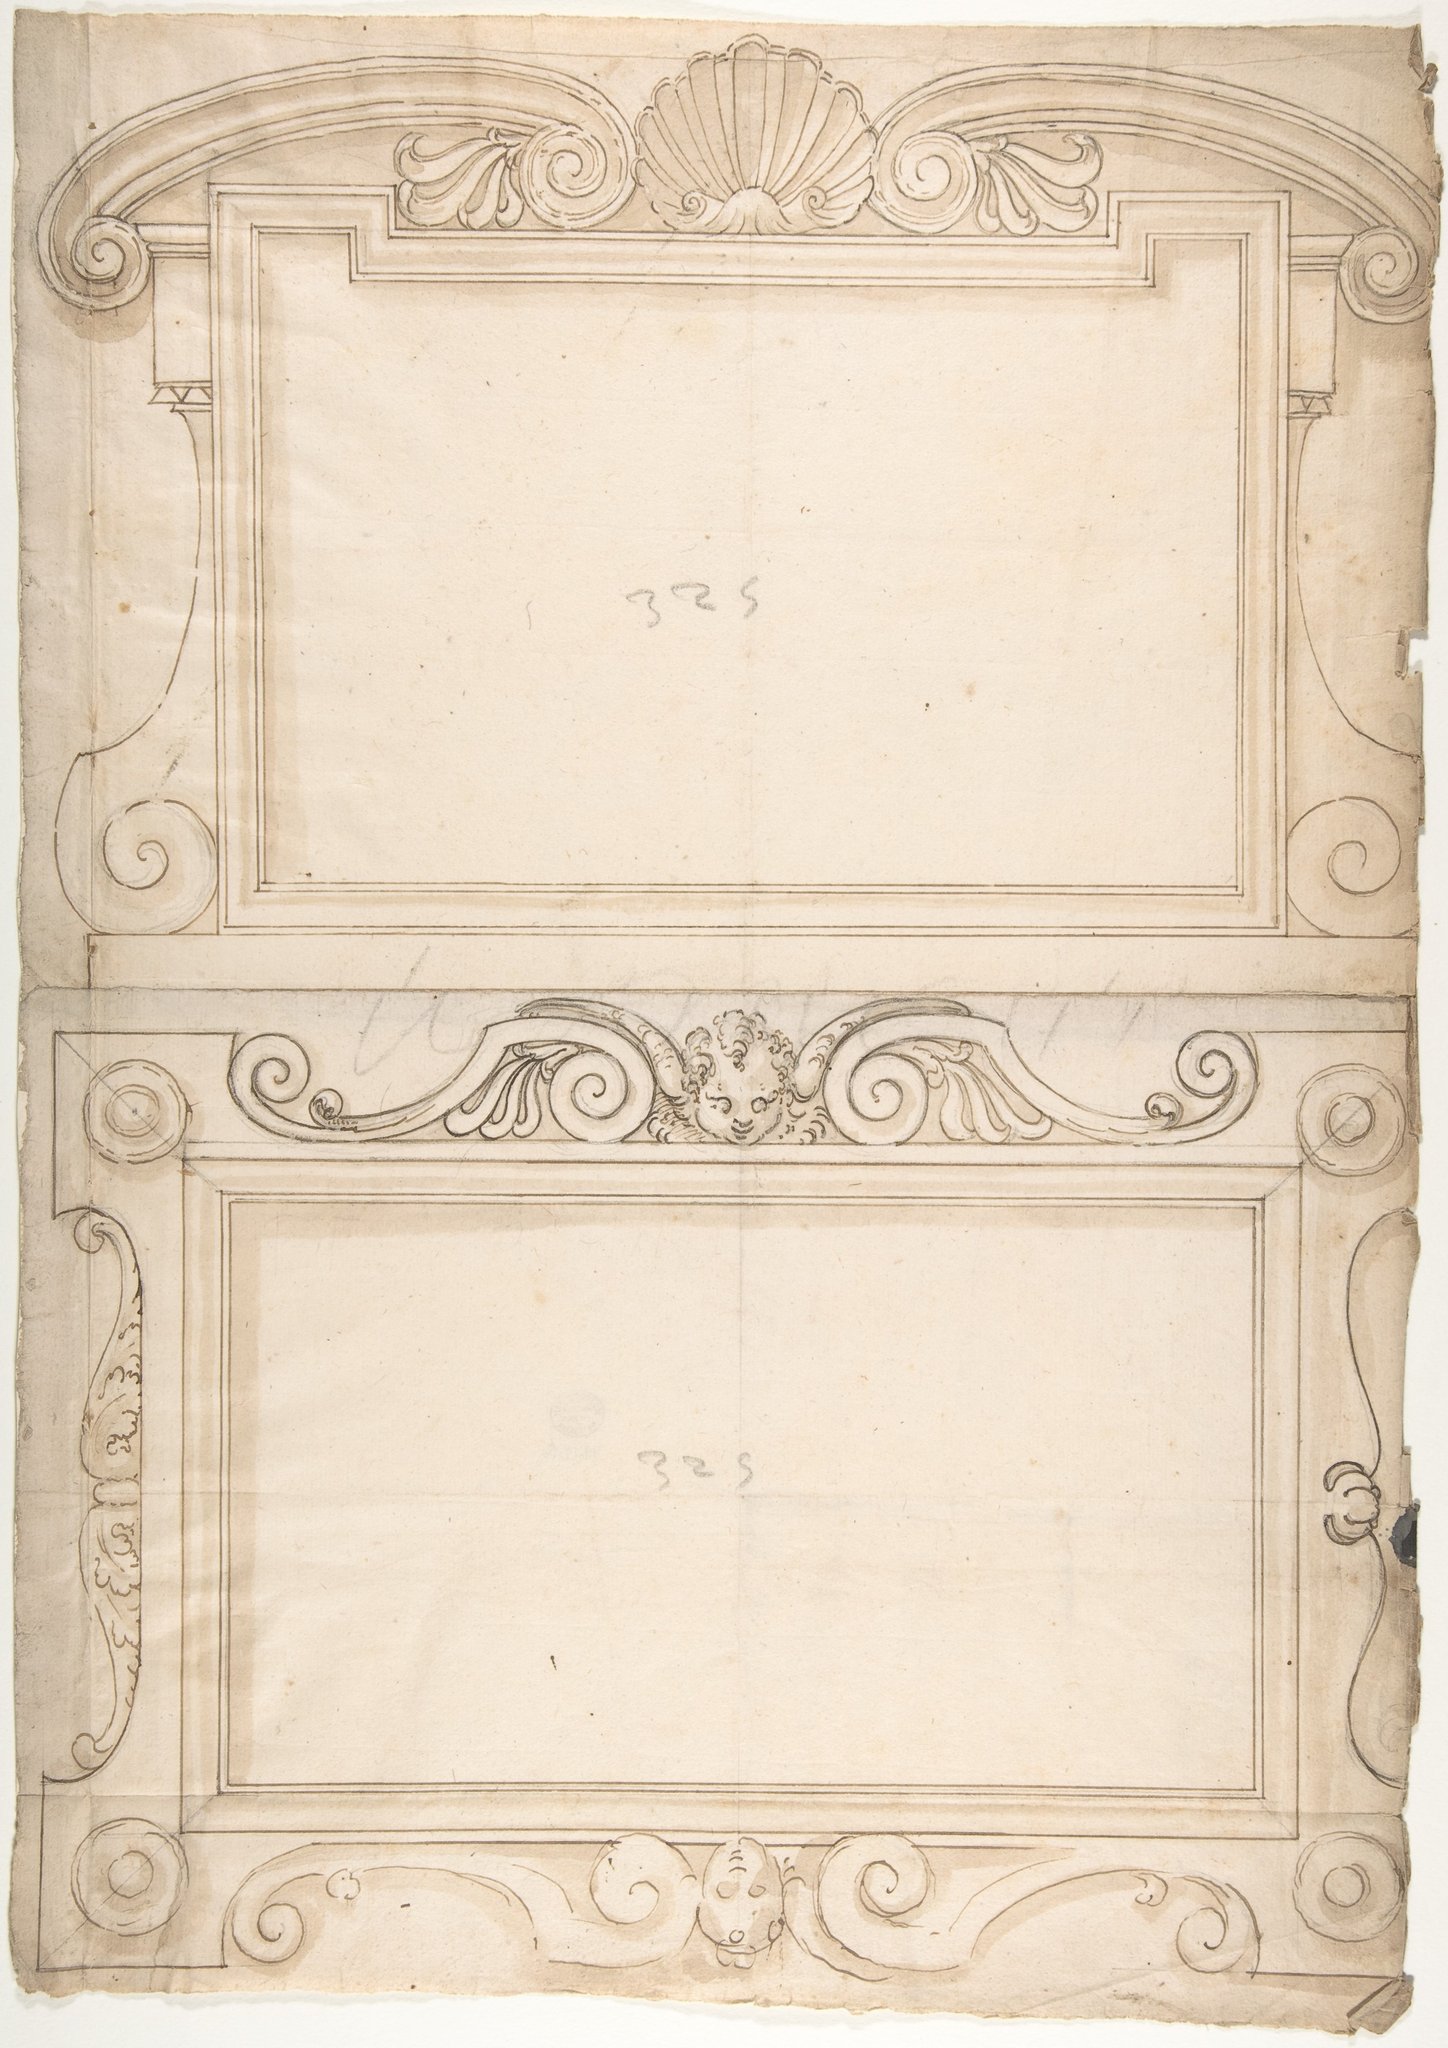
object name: drawing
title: Two Designs for Carved Panels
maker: anonymous, french, 16th century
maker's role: artist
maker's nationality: french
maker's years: 1500-1600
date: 1501-1600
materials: chalk, ink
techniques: brush, pen, wash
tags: architecture